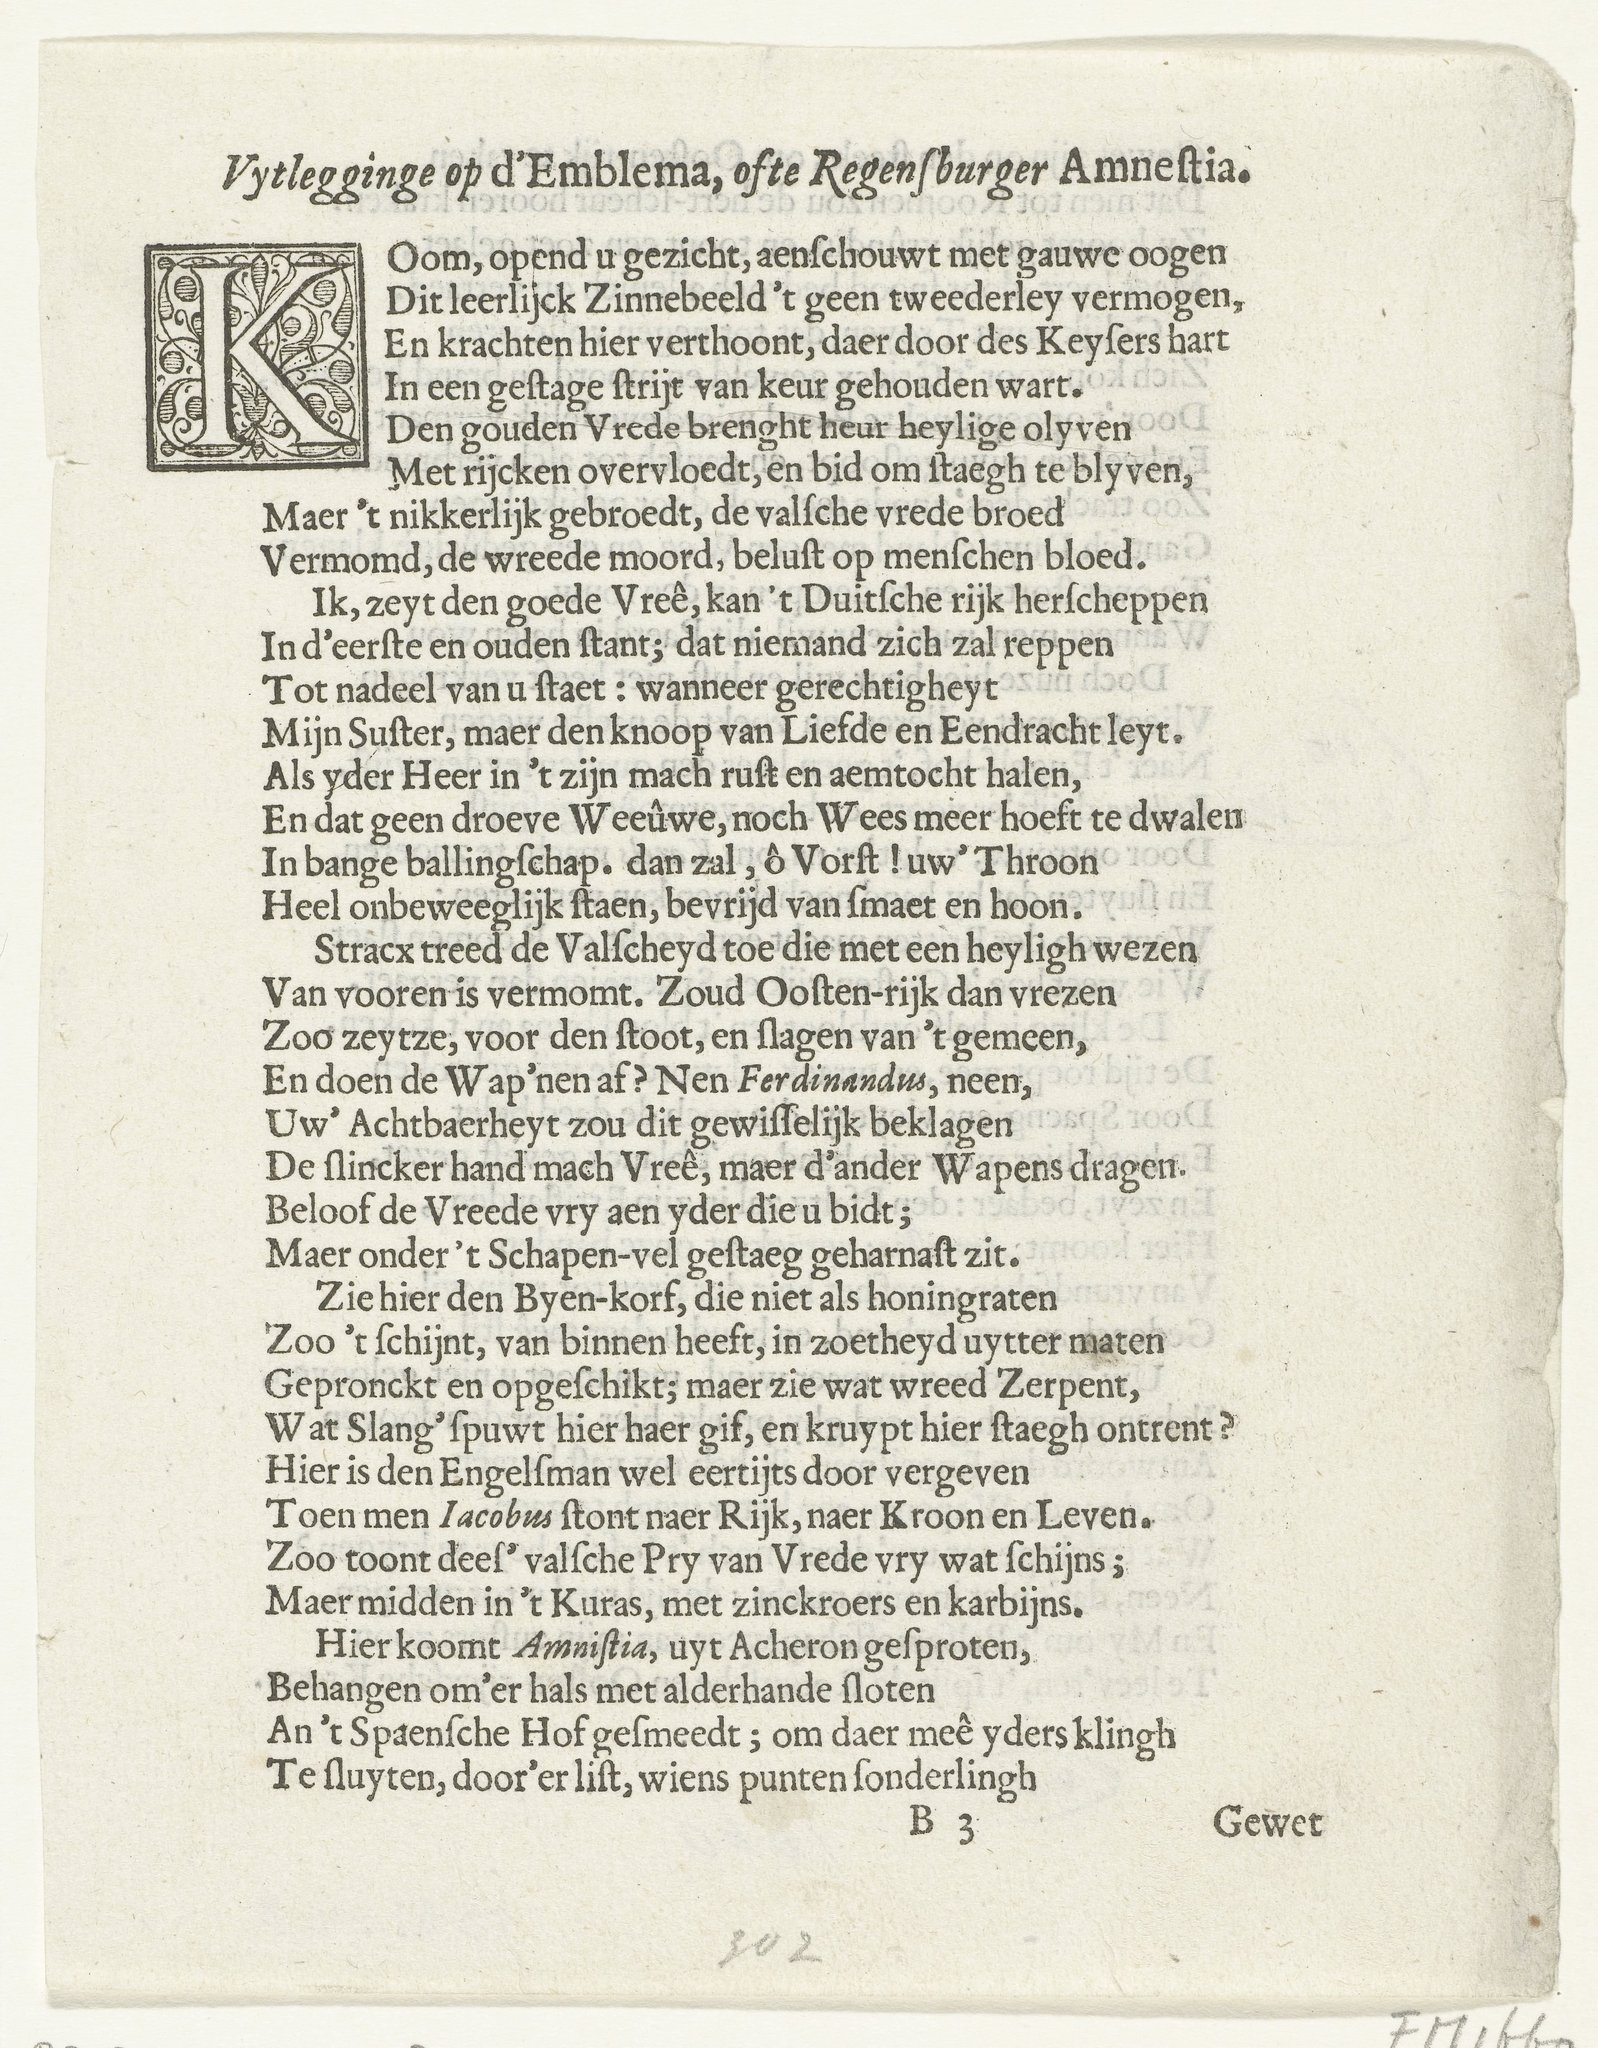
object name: text sheet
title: Uytlegginge op d'Emblema, ofte Regenburger Amnestia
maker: p. foreri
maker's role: schrijver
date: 1641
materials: paper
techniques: letterpress printing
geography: northern netherlands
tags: vienna, ferdinand iii (duits keizer)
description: Tekstblad met uitleg in versvorm behorend bij de allegorie op de voorgestelde Regensburger Amnestie, vredesbesprekingen te Regensburg om de Dertigjarige oorlog te beëindigen, 1640-1641. Pagina met tekst over twee bladzijden. Afkomstig uit het pamflet Radelijcke bedenckinge, door P. Foreri, 1641.